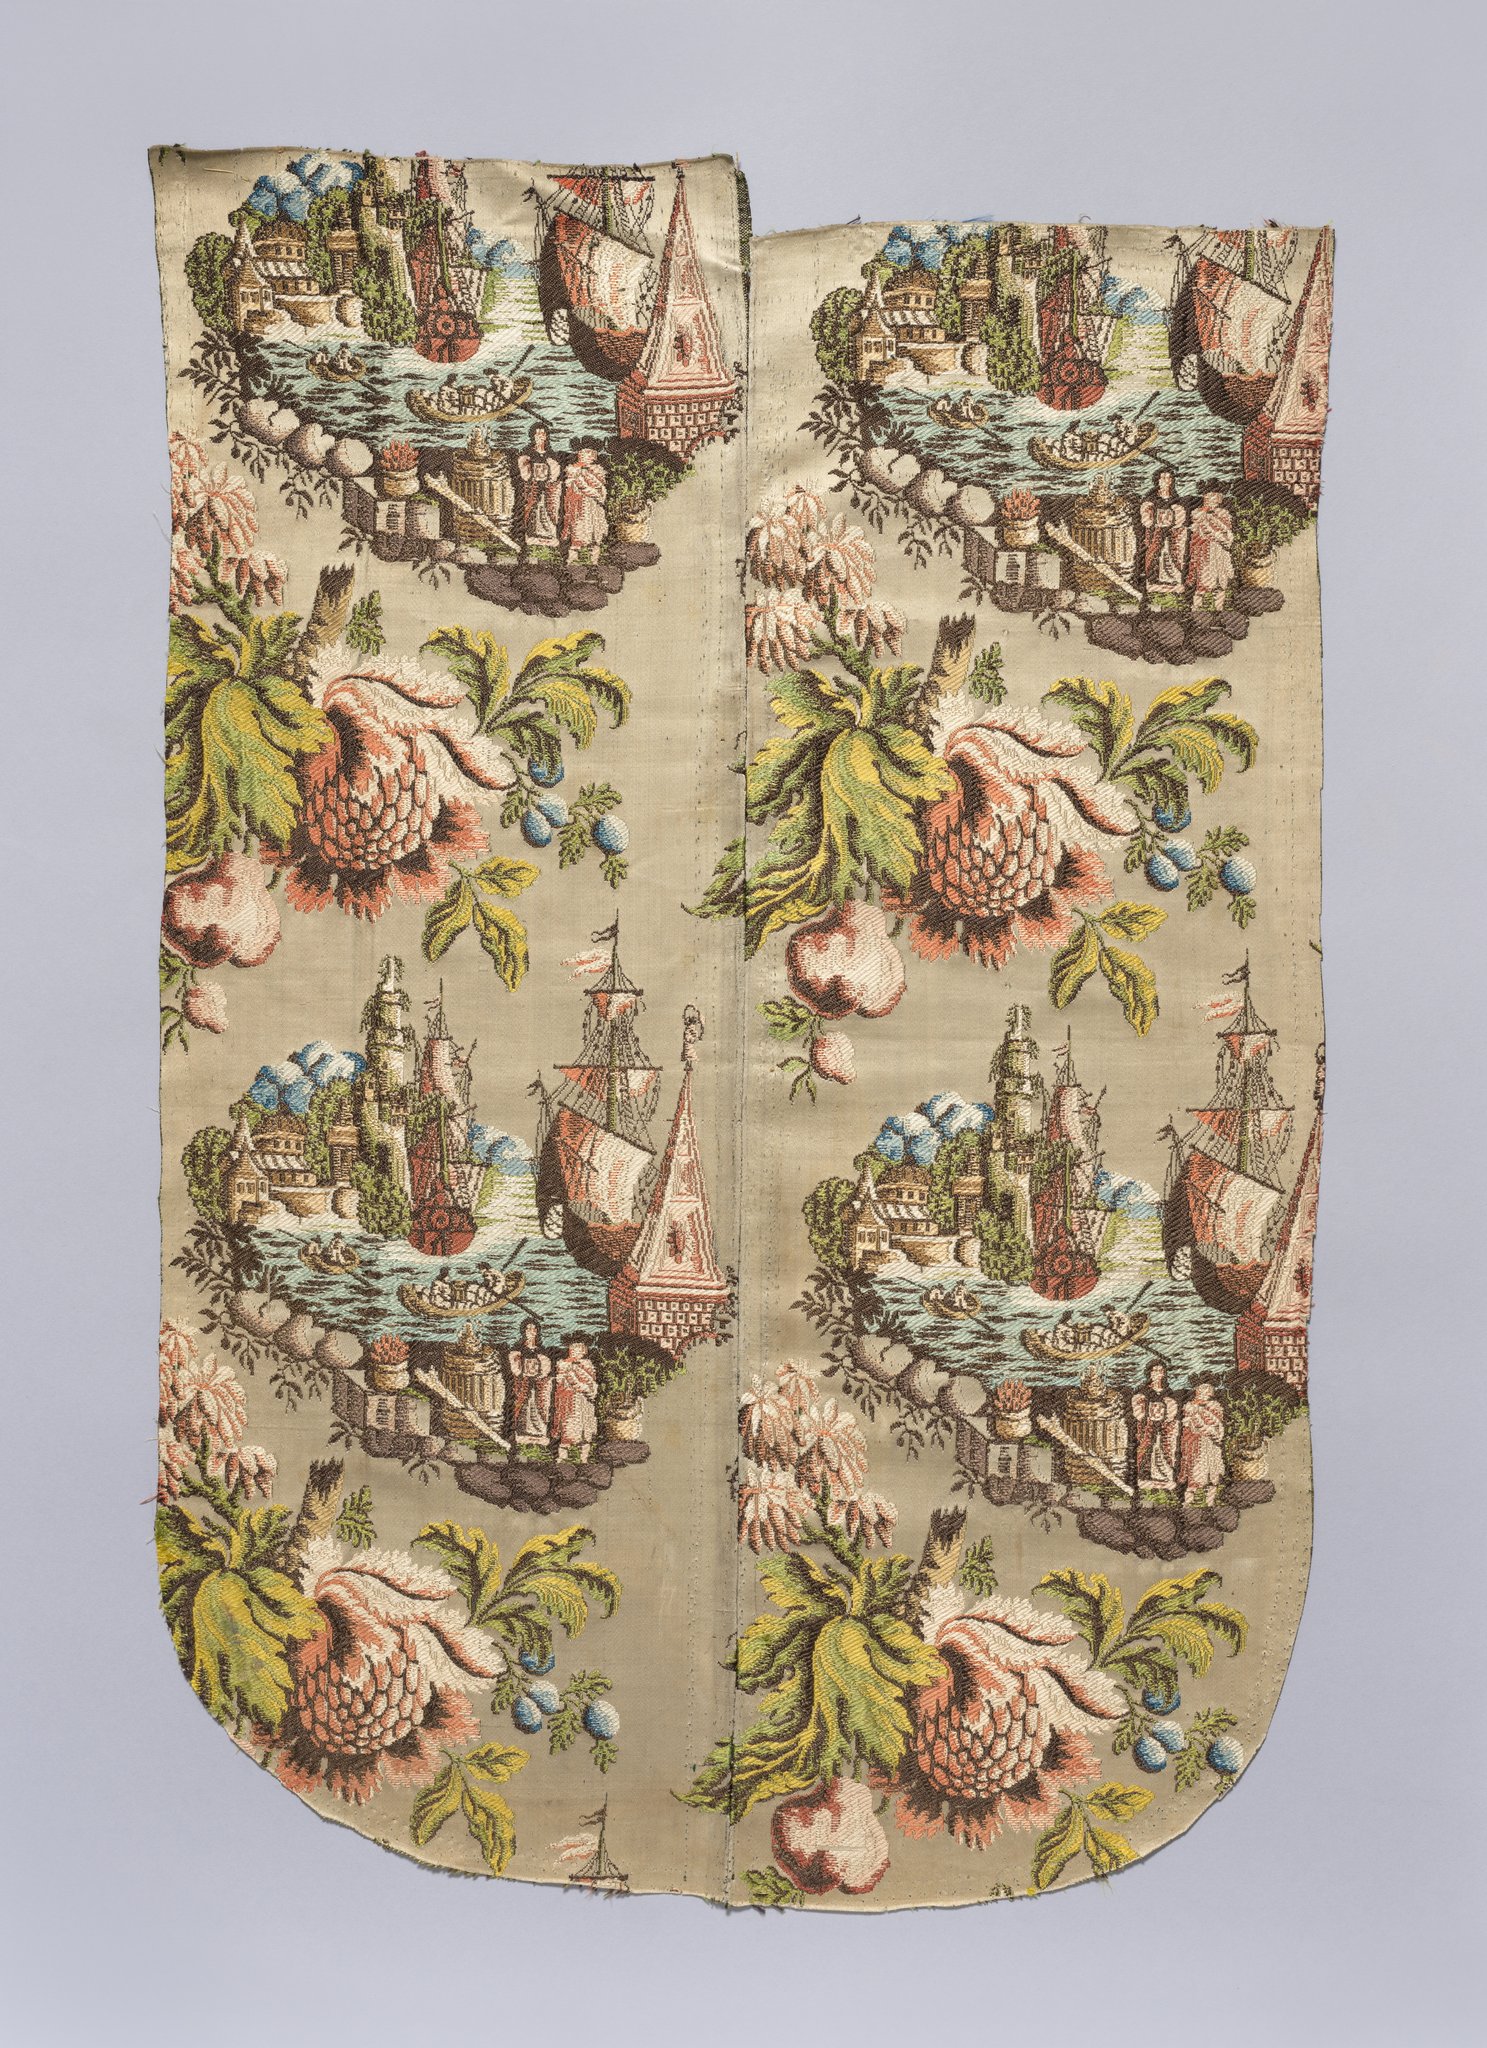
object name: piece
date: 1735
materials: silk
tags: boats